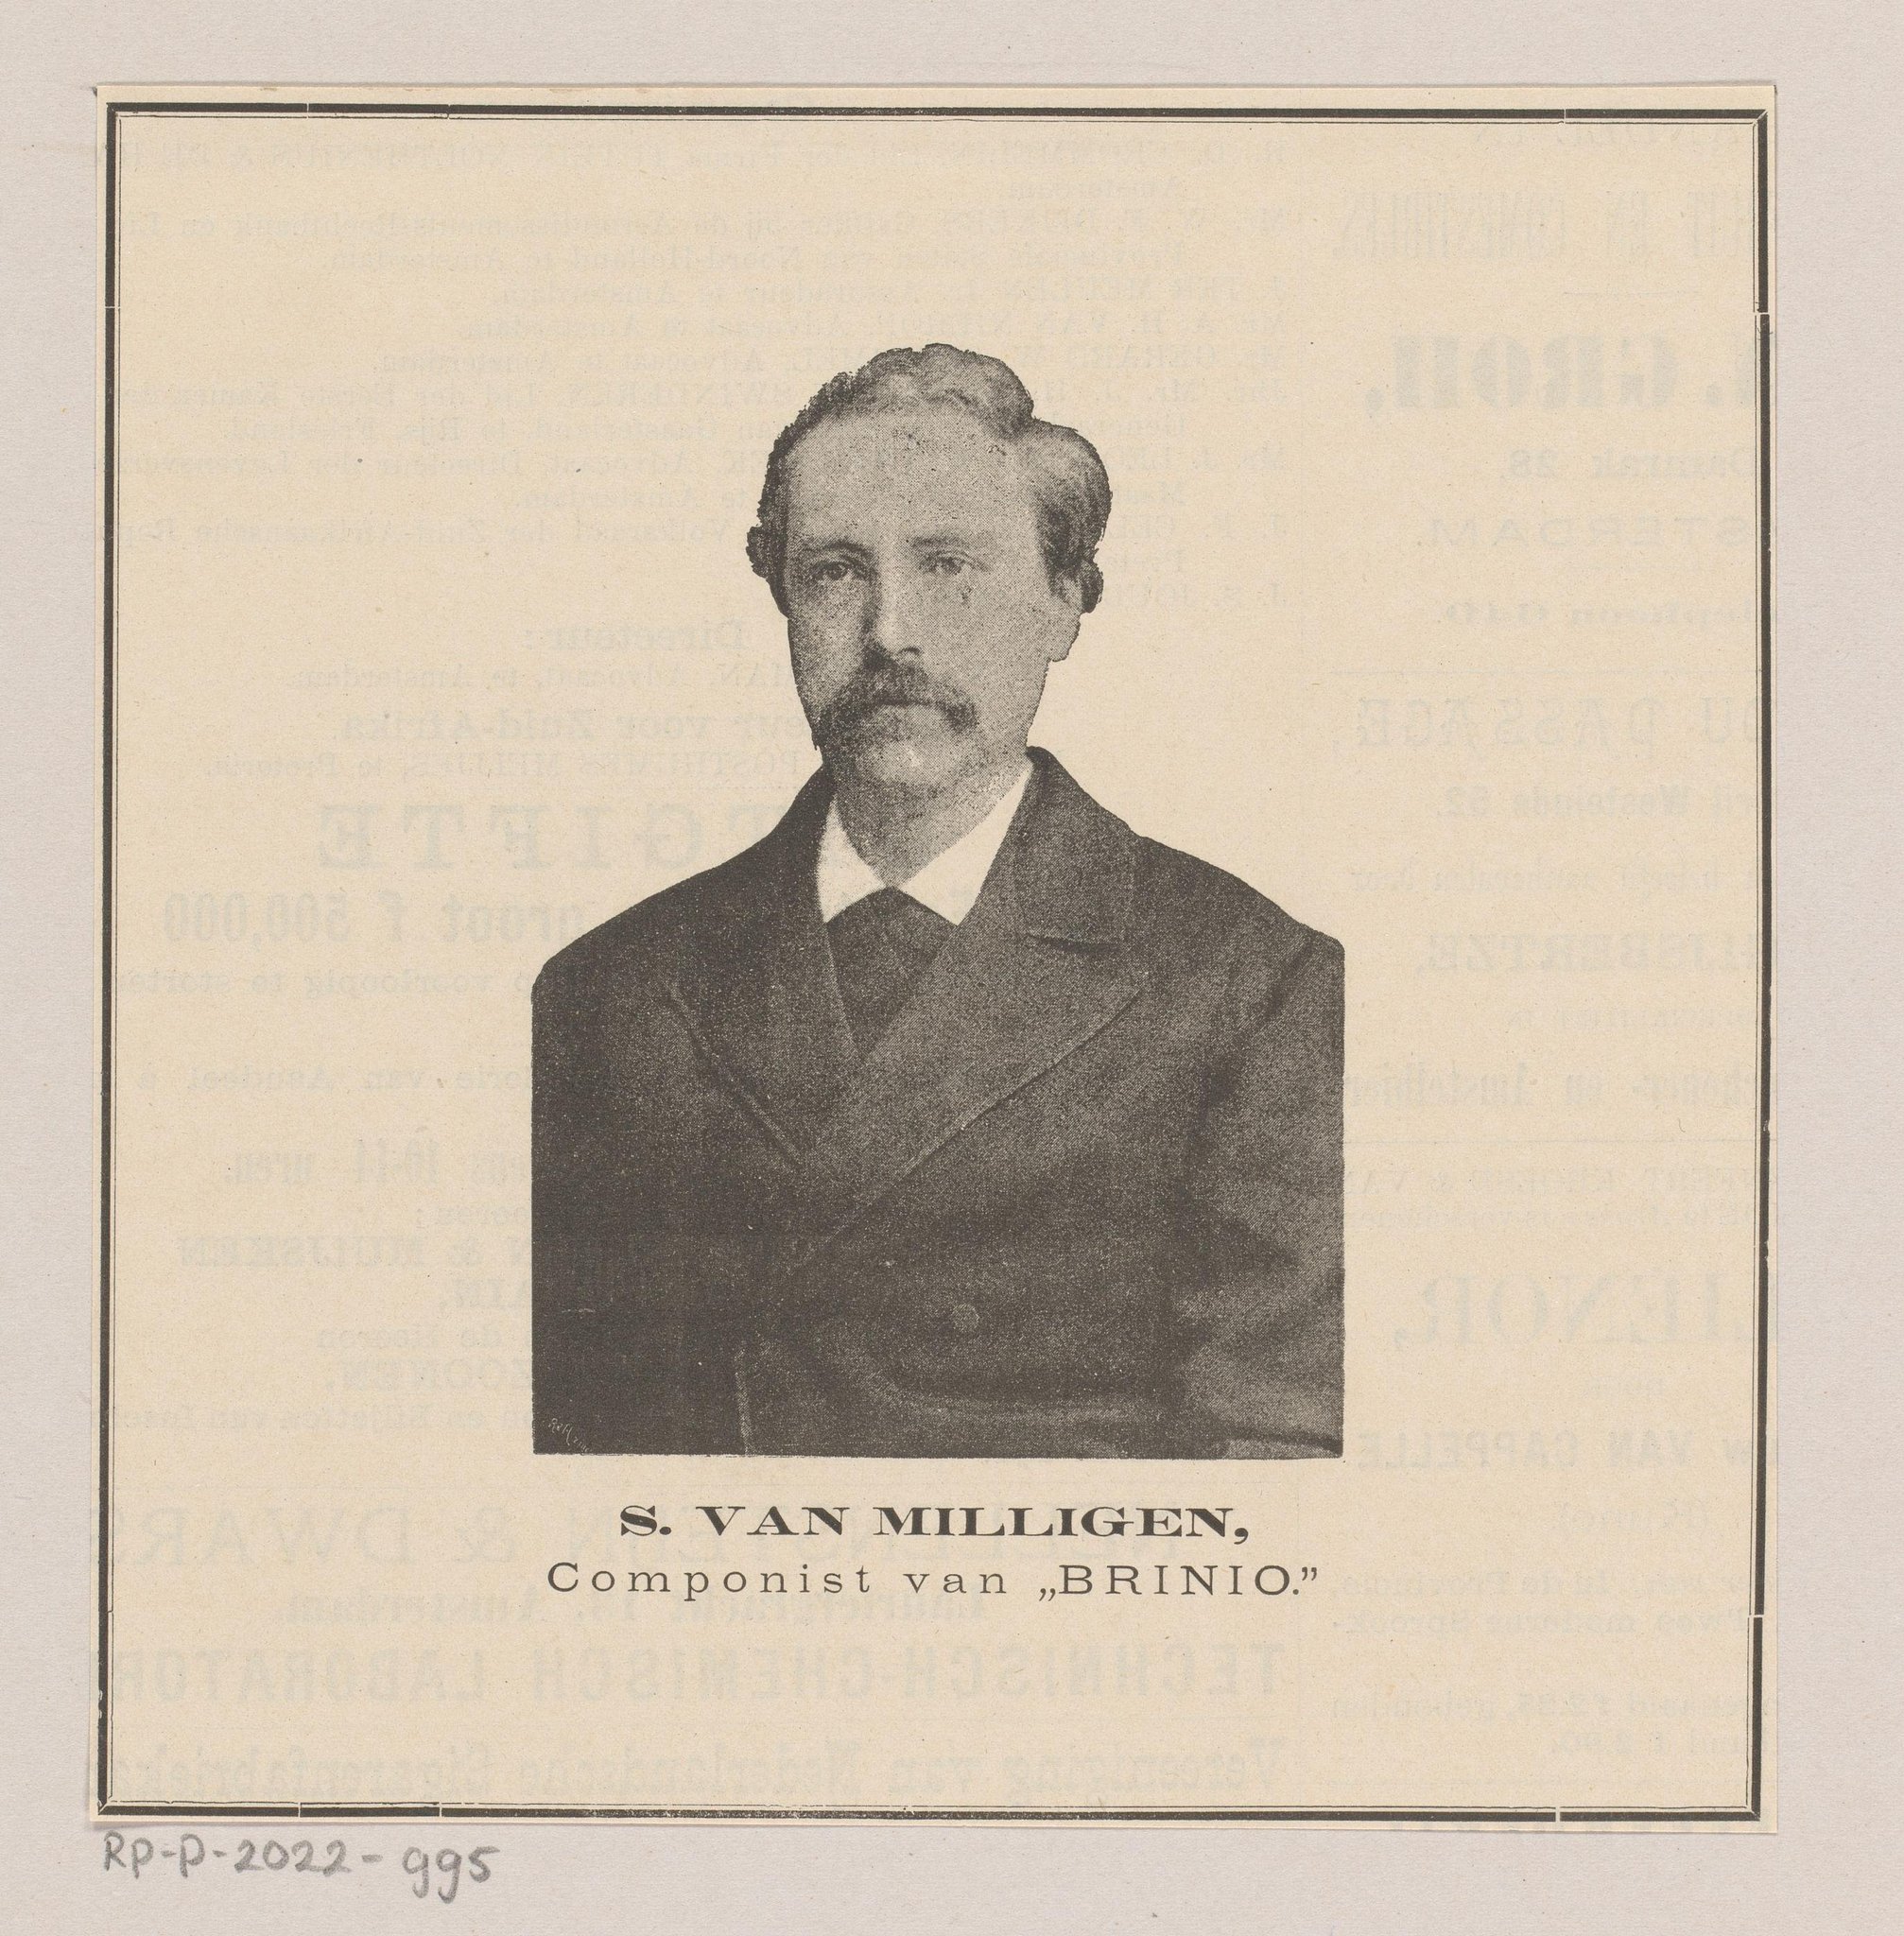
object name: newspaper clipping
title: S. van Milligen, Componist van "Brinio"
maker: Anonymous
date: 1889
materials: paper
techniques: letterpress printing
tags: historical persons, portrait of composer